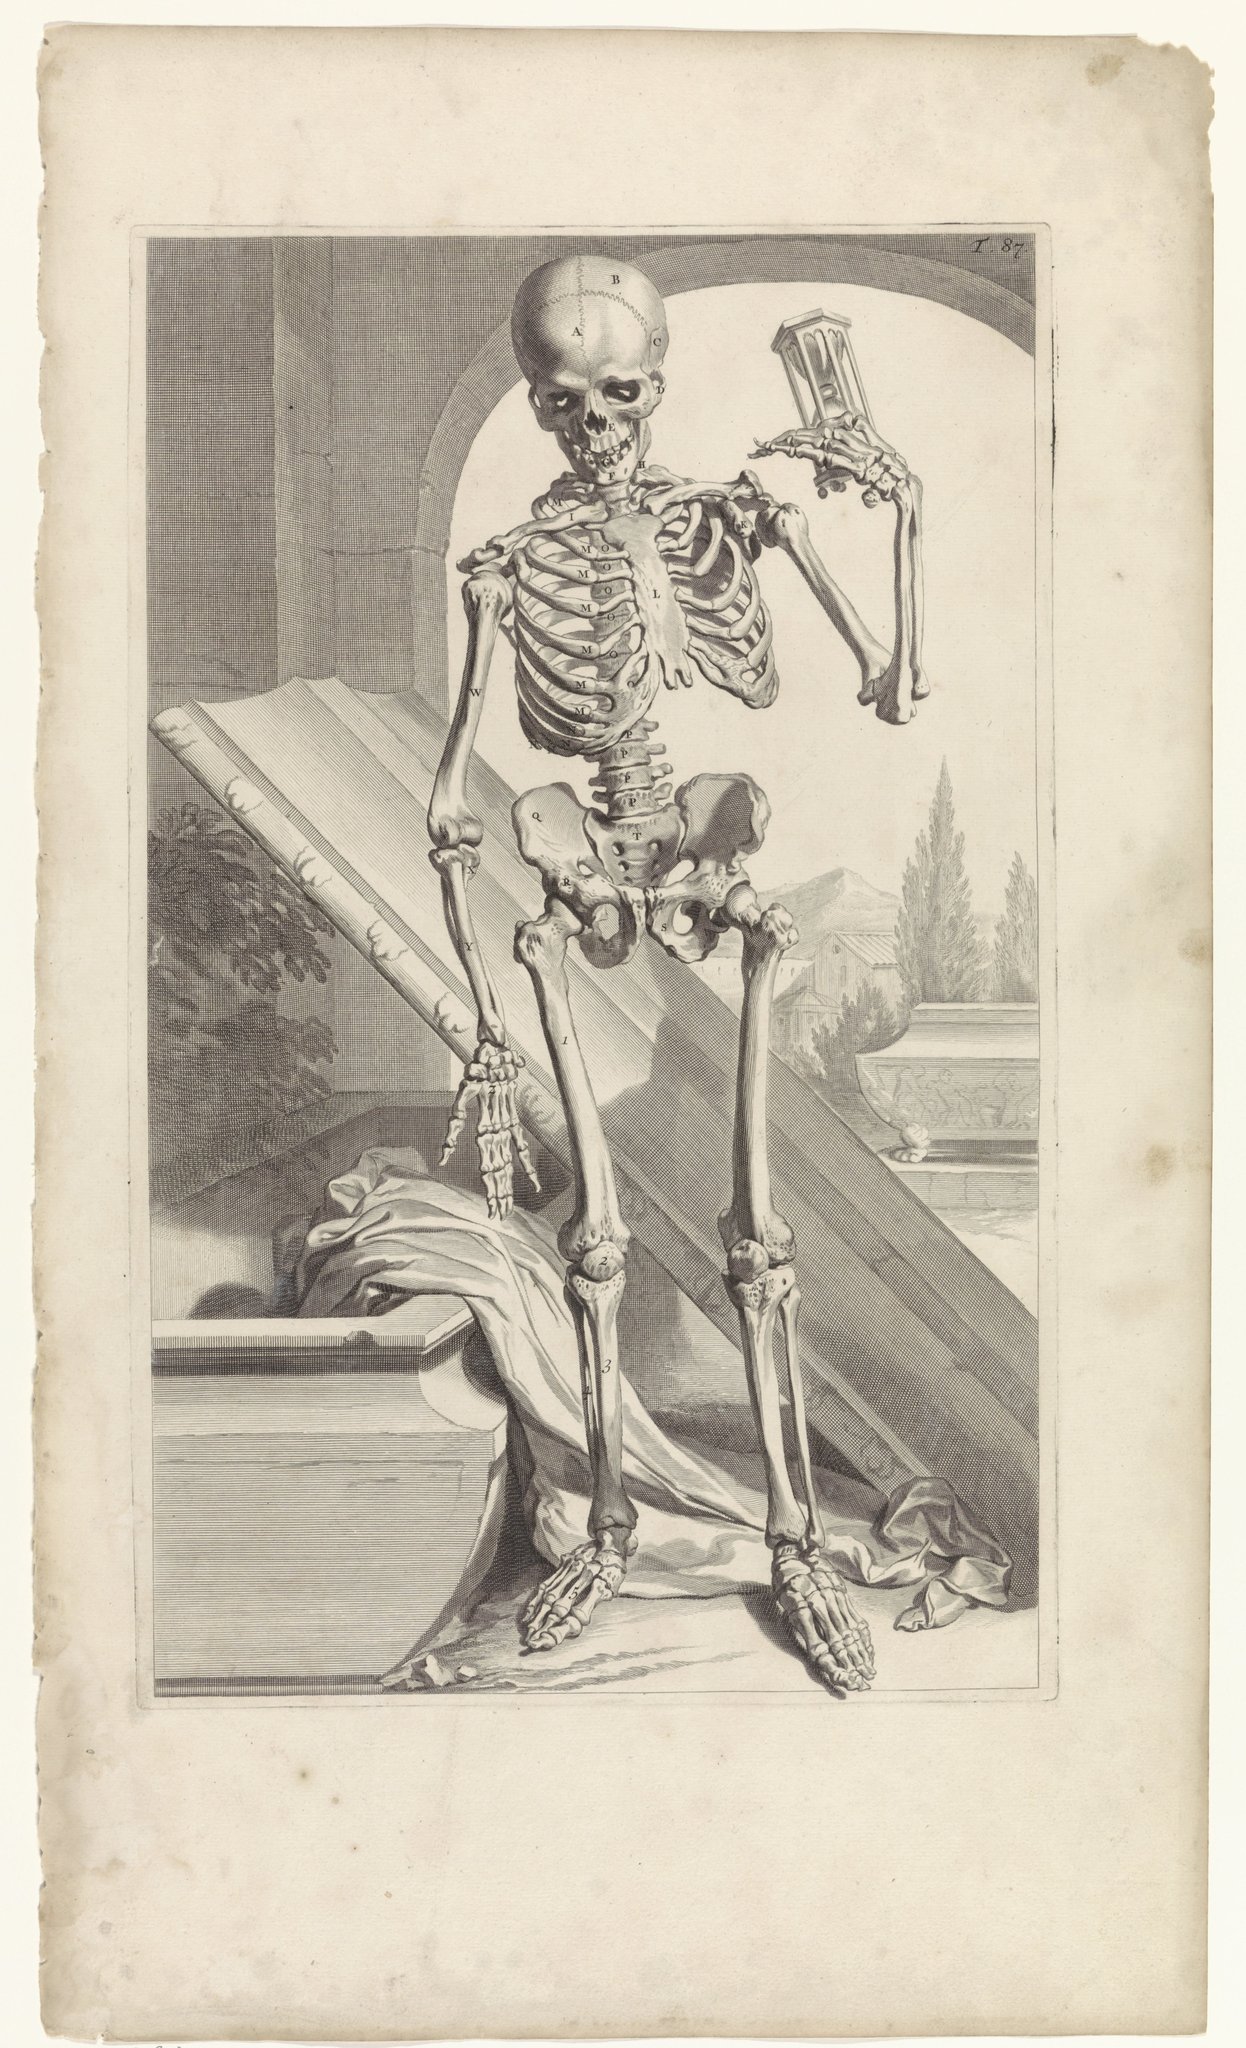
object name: print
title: Anatomische model van een menselijk skelet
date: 1685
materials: paper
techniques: engraving, etching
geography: amsterdam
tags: resurrection; 'ressurrettione' (ripa), grave, tomb, hourglass, (human) skeleton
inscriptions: collector's mark: Lugt 2228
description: Boekillustratie voor Bidloo, Godefridus. Anatomia humani corporis centum & quinque tabulis, per art. G. de Lairesse ad vivum delineatis, de monstrata, veterum recentiorumque inventis explicata plurimisque, hactenus non detectis, illustrata. Amsterdam: Weduwe Joannes van Someren, Hendrick Boom en erven Dirk Boom, 1685.